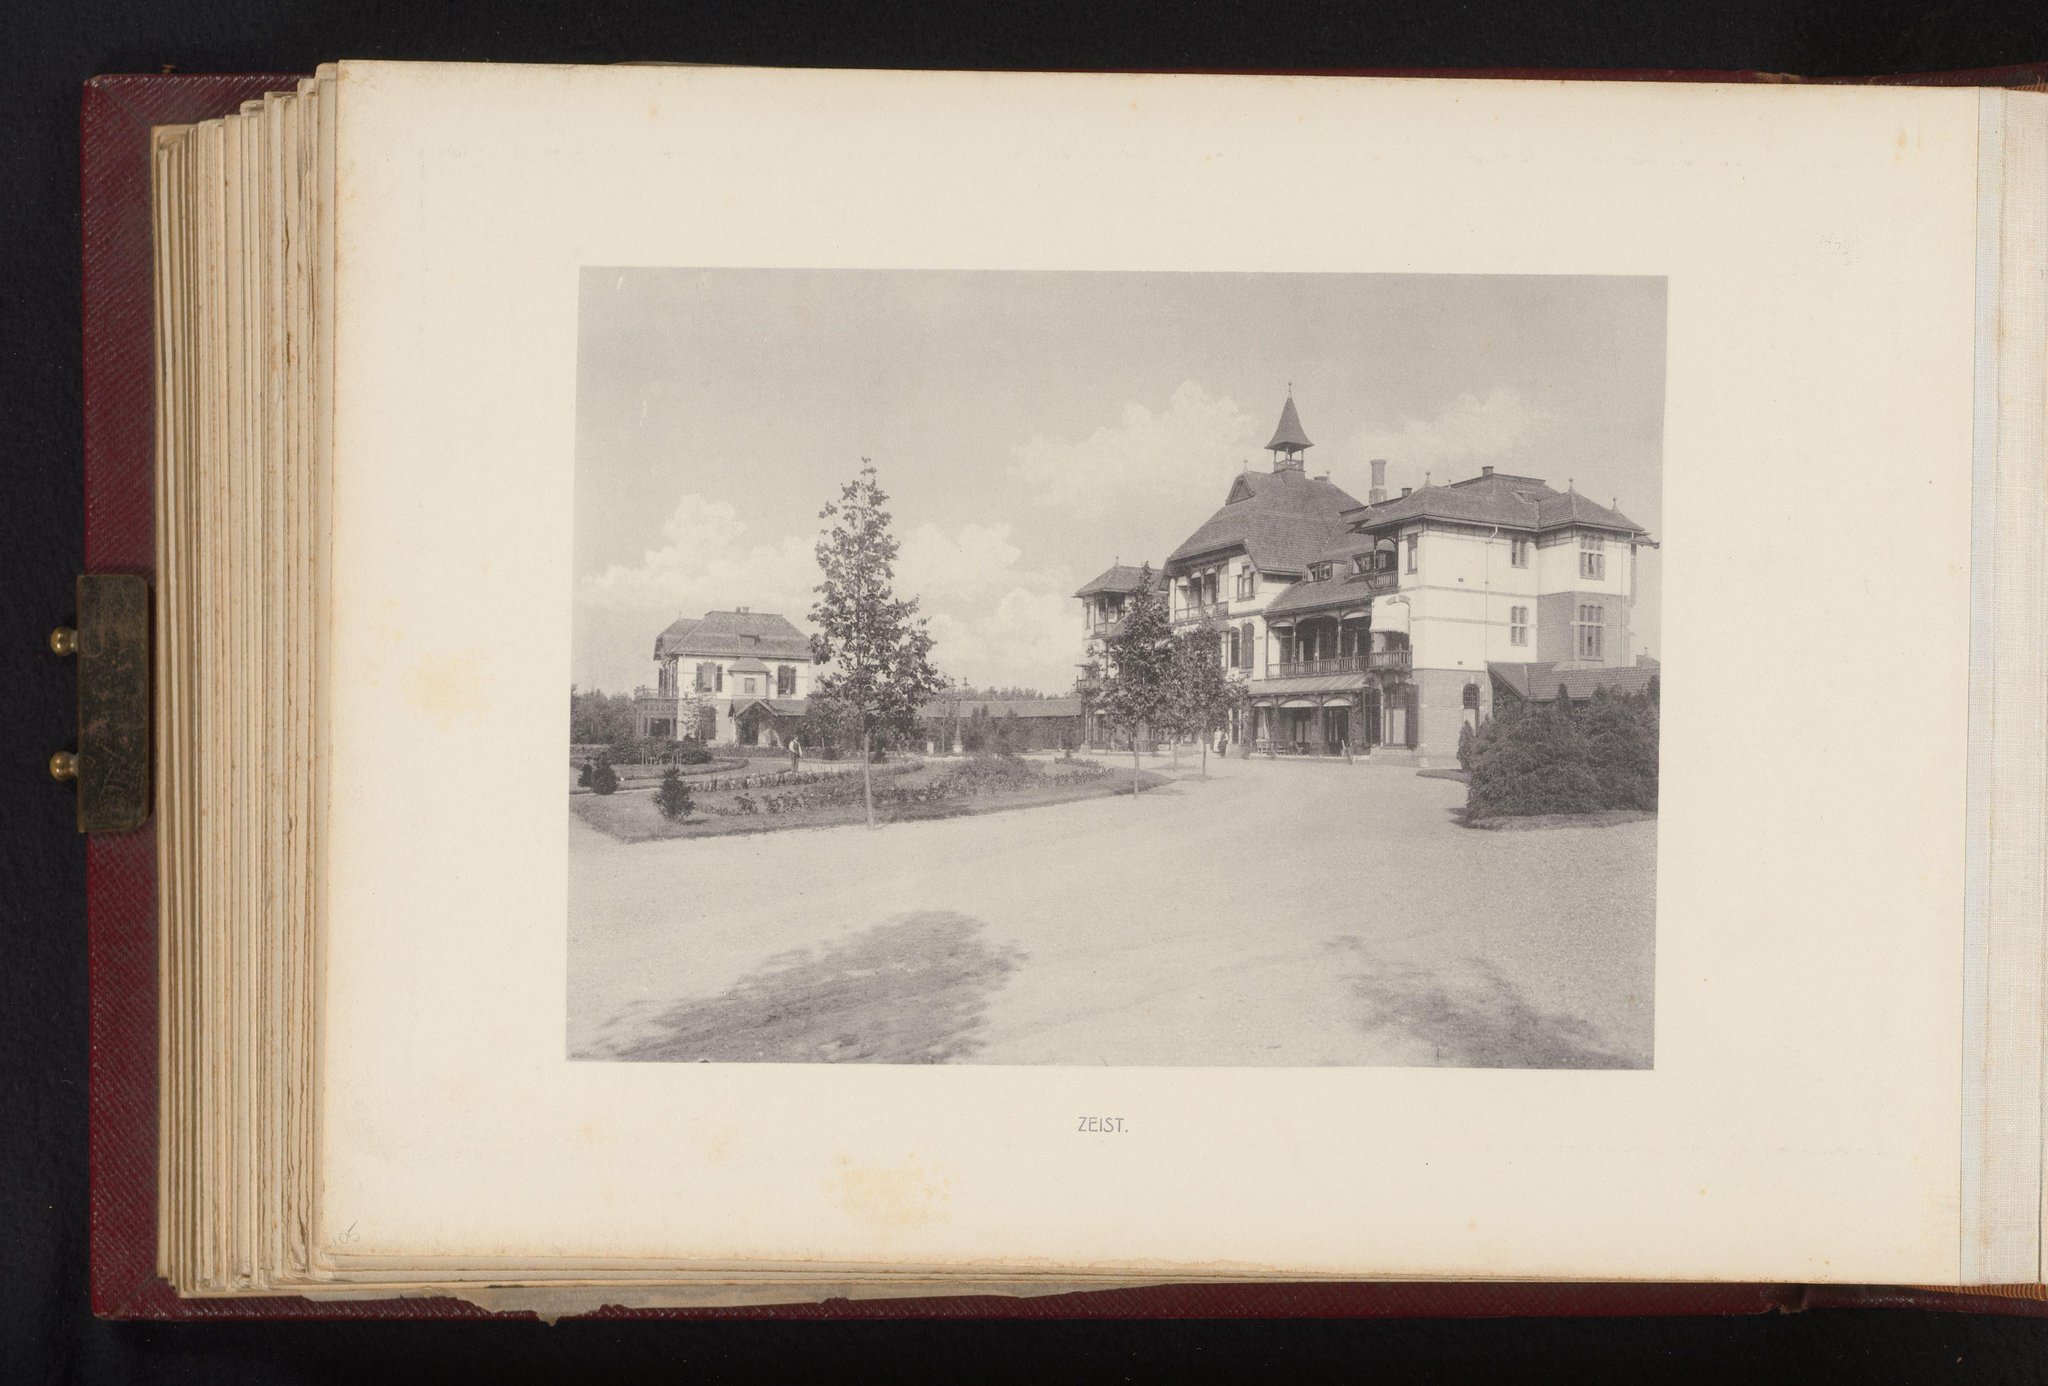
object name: album leaf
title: Gebouwen te Zeist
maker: Anonymous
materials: paper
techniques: photograph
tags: civic architecture; edifices; dwellings, zeist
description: Deze pagina maakt deel uit van een album.